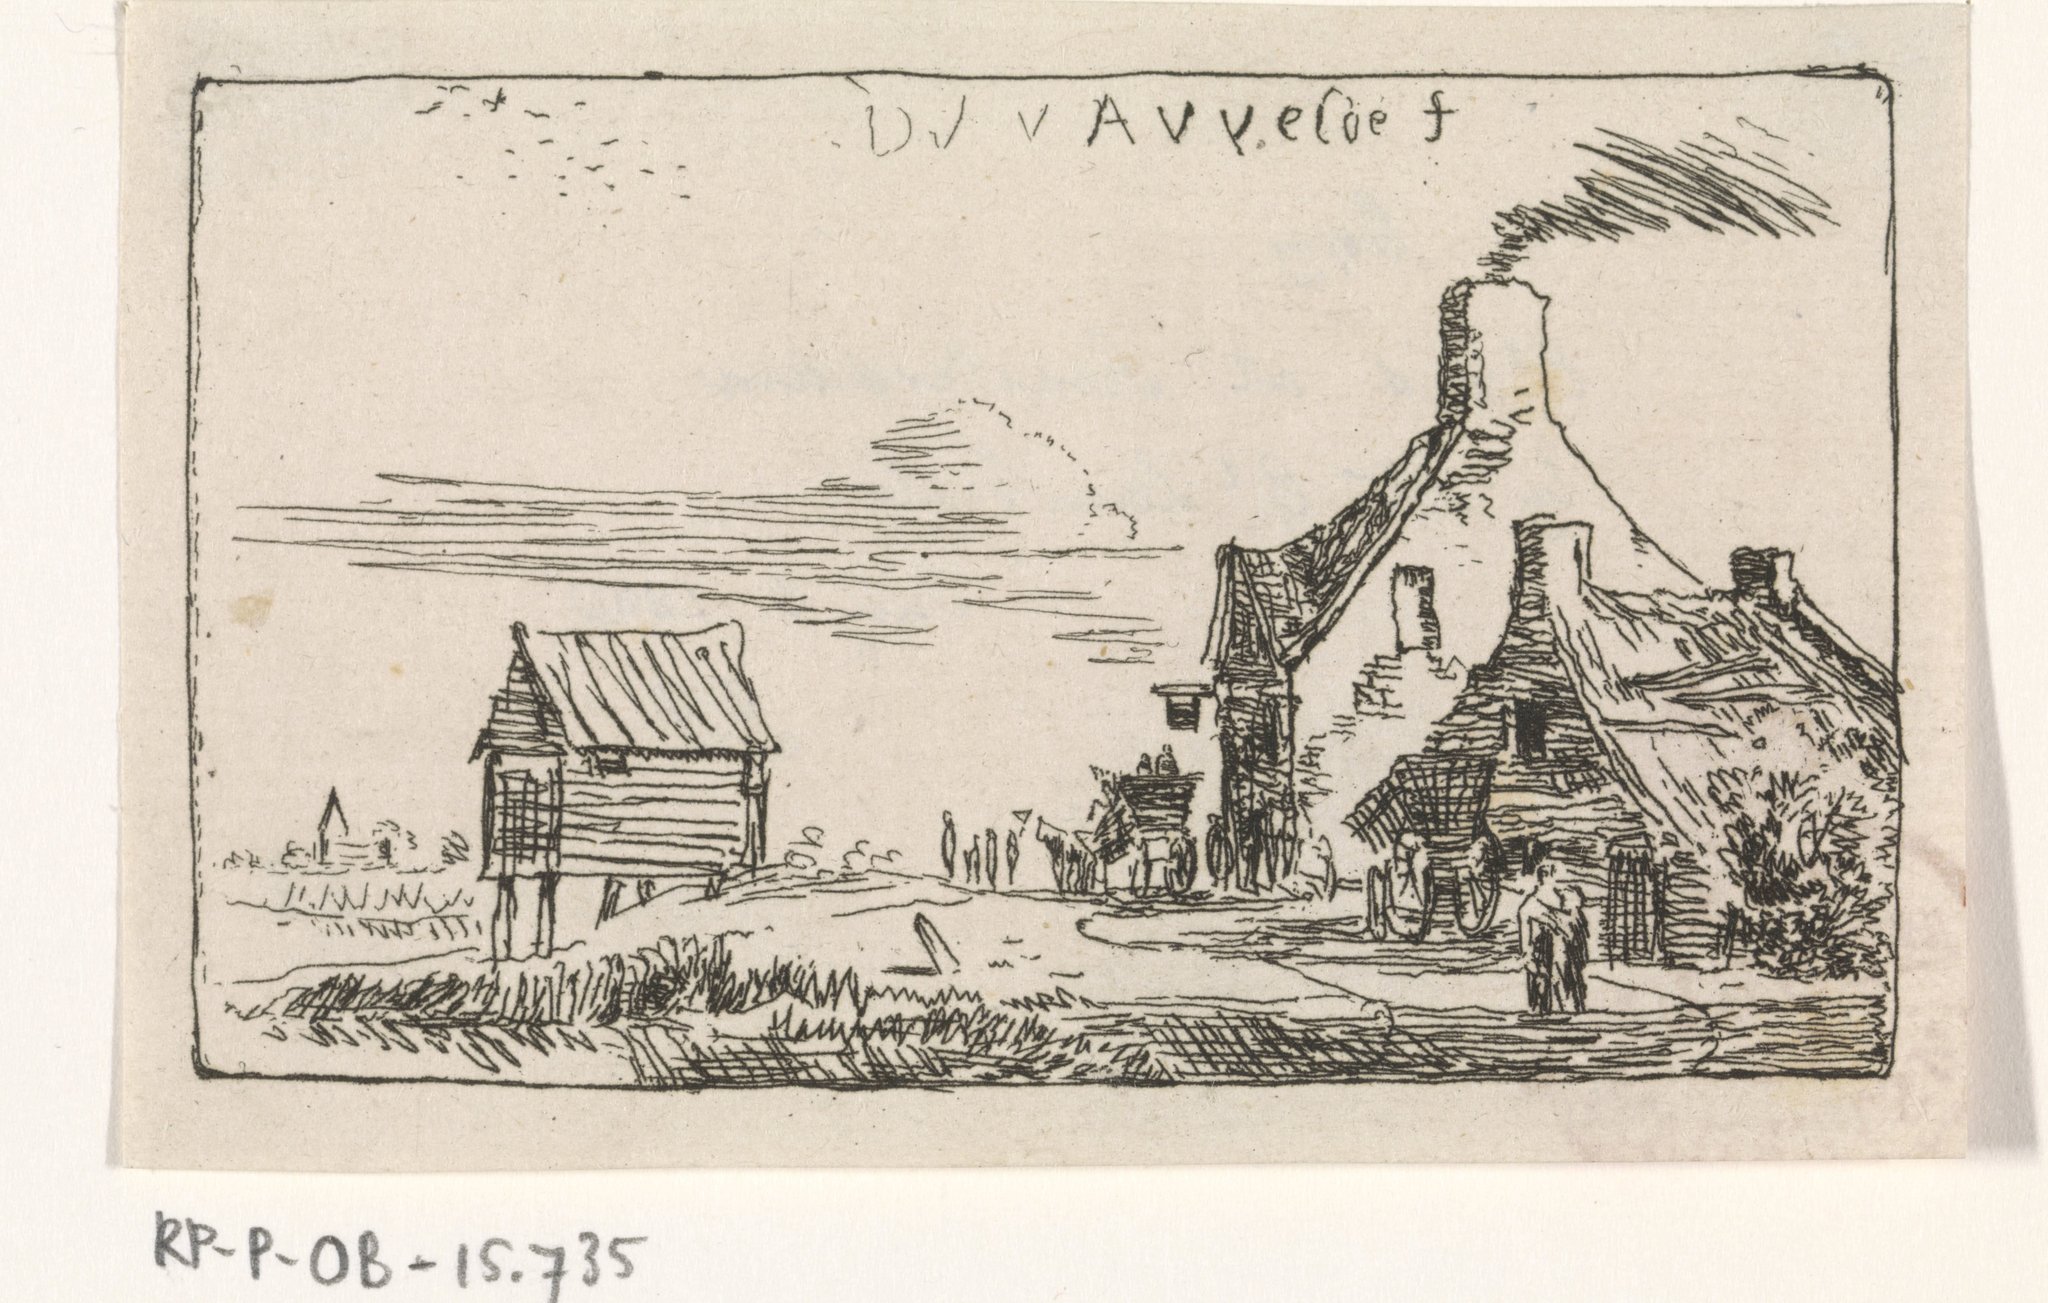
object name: print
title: Landschap met een wagen bij een herberg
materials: paper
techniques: etching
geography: amsterdam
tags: chimney, hotel, hostelry, inn, (farm) wagon, freight wagon, cart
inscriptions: collector's mark: Lugt 12